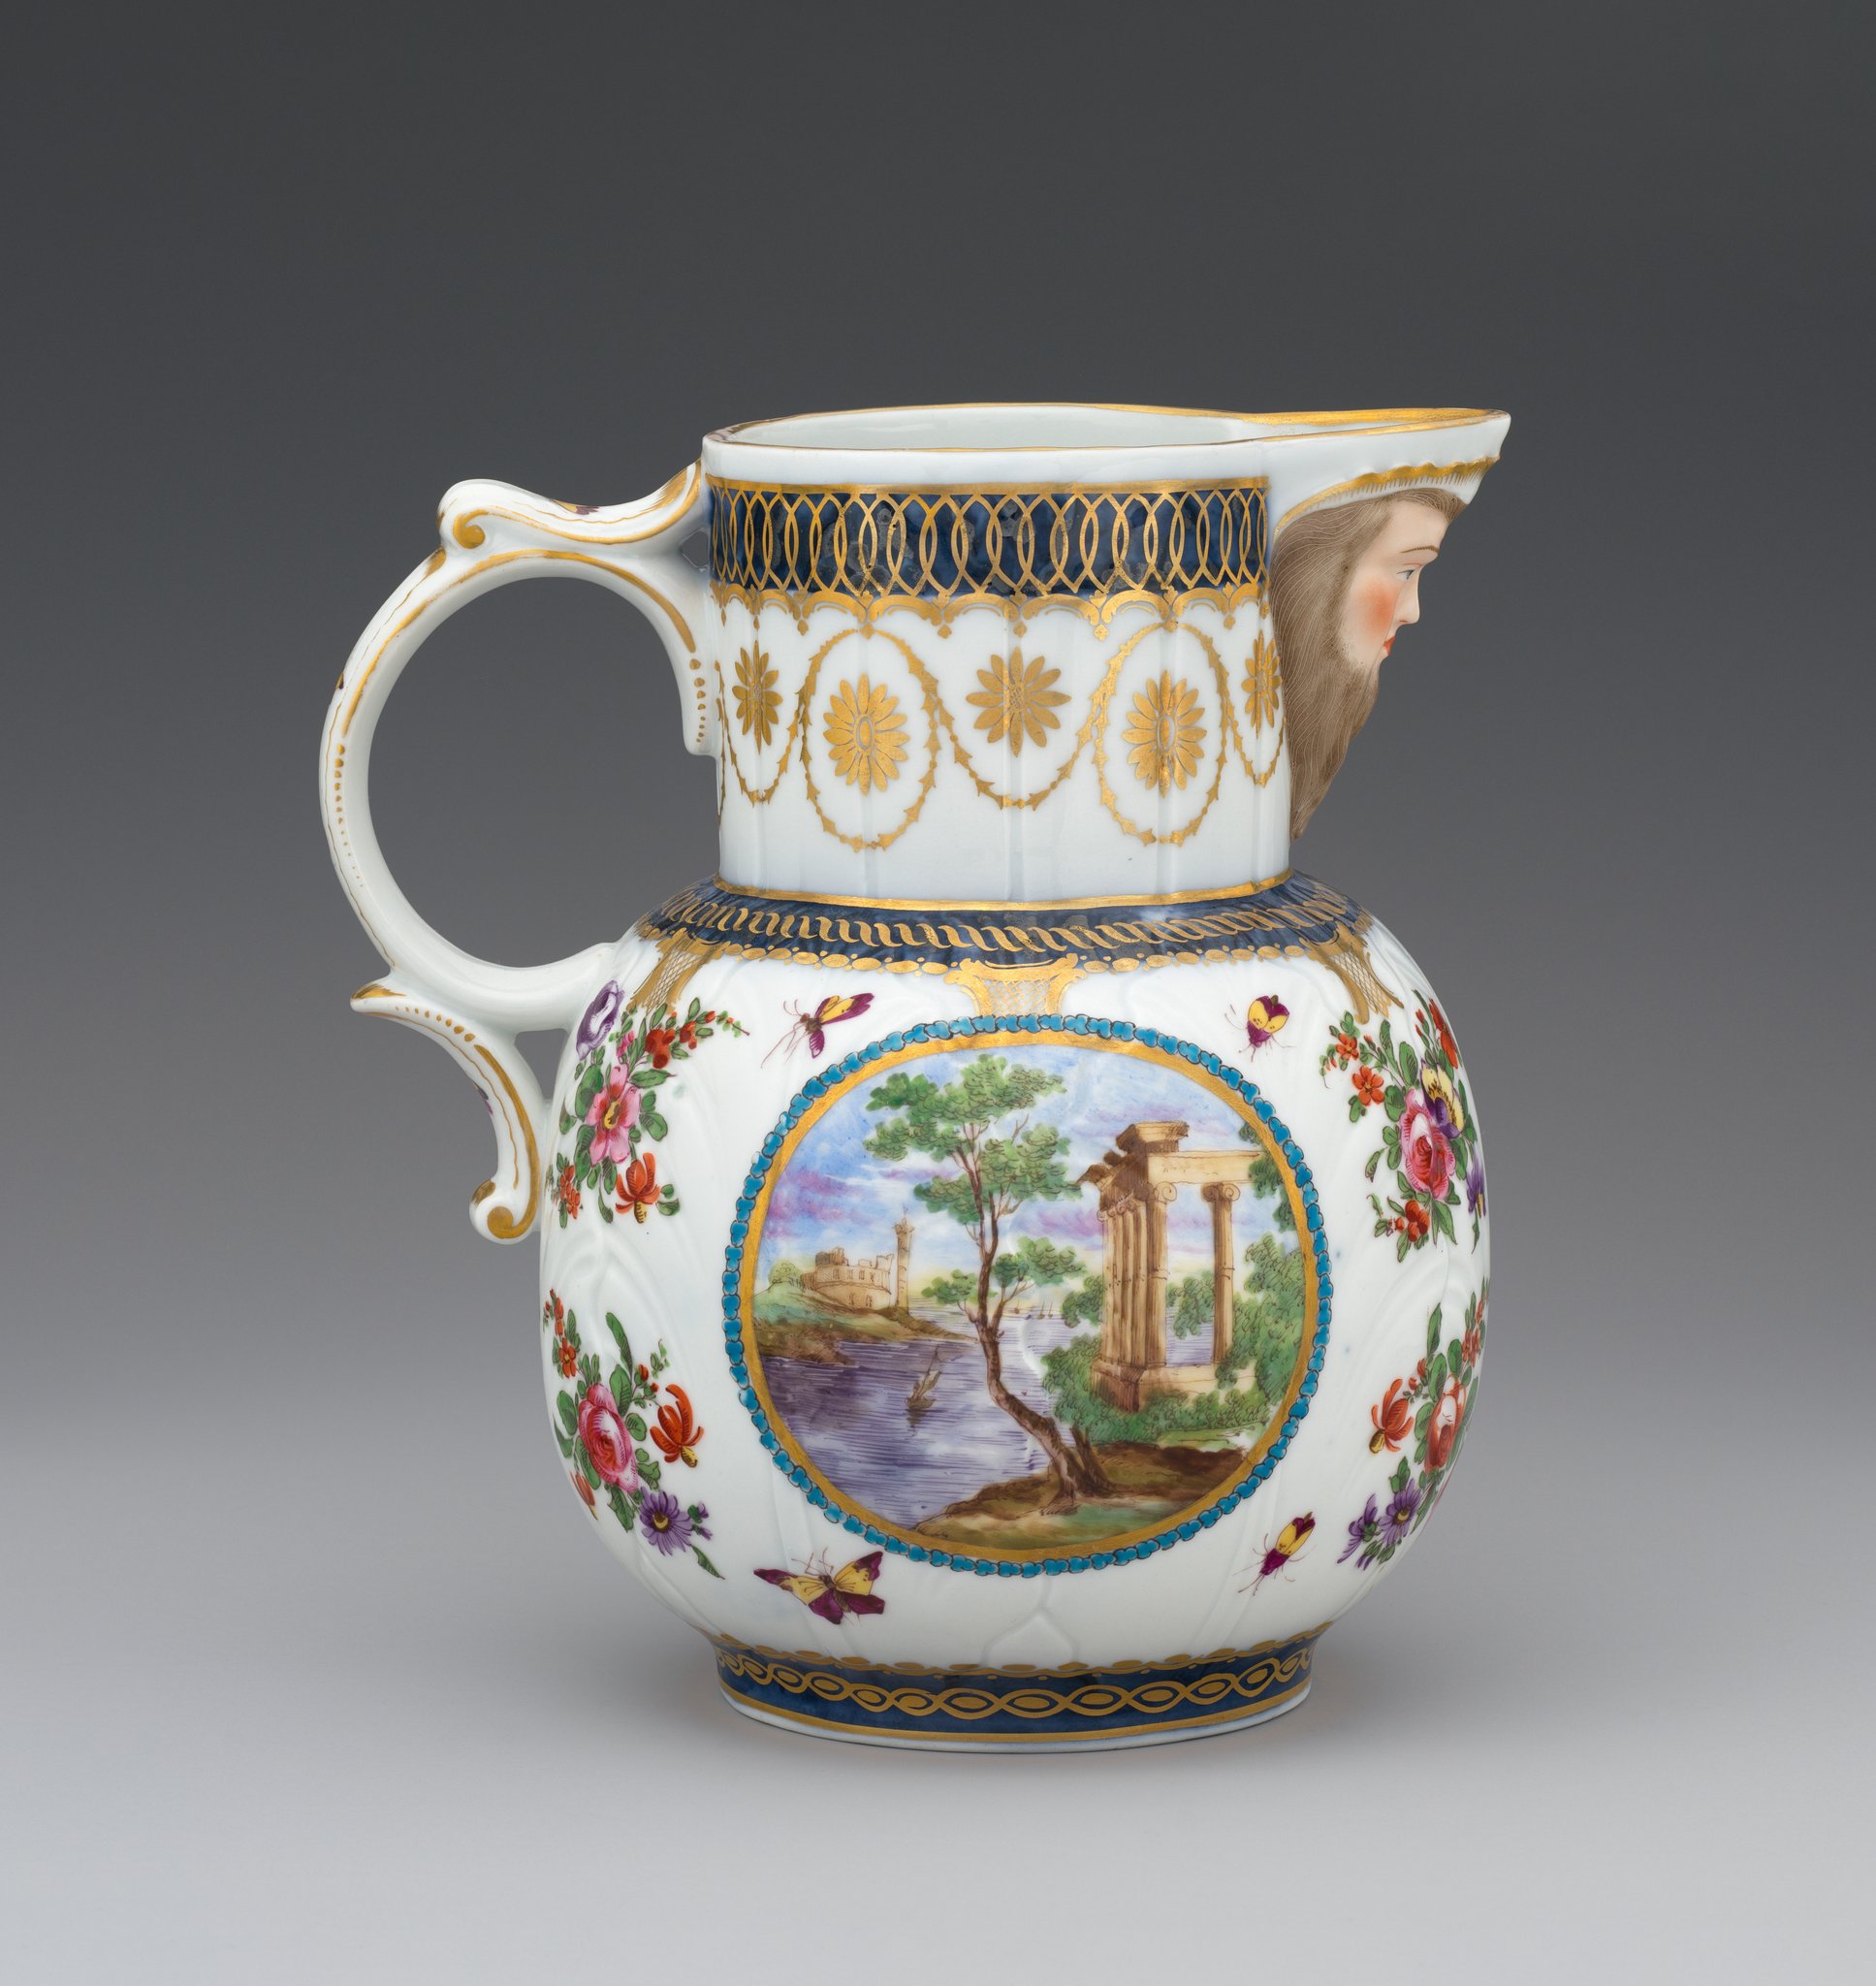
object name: jug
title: Jug in the style of Worcester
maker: edmé samson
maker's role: maker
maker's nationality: french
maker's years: 1810-1891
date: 1801-1900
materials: hard paste porcelain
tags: ruins